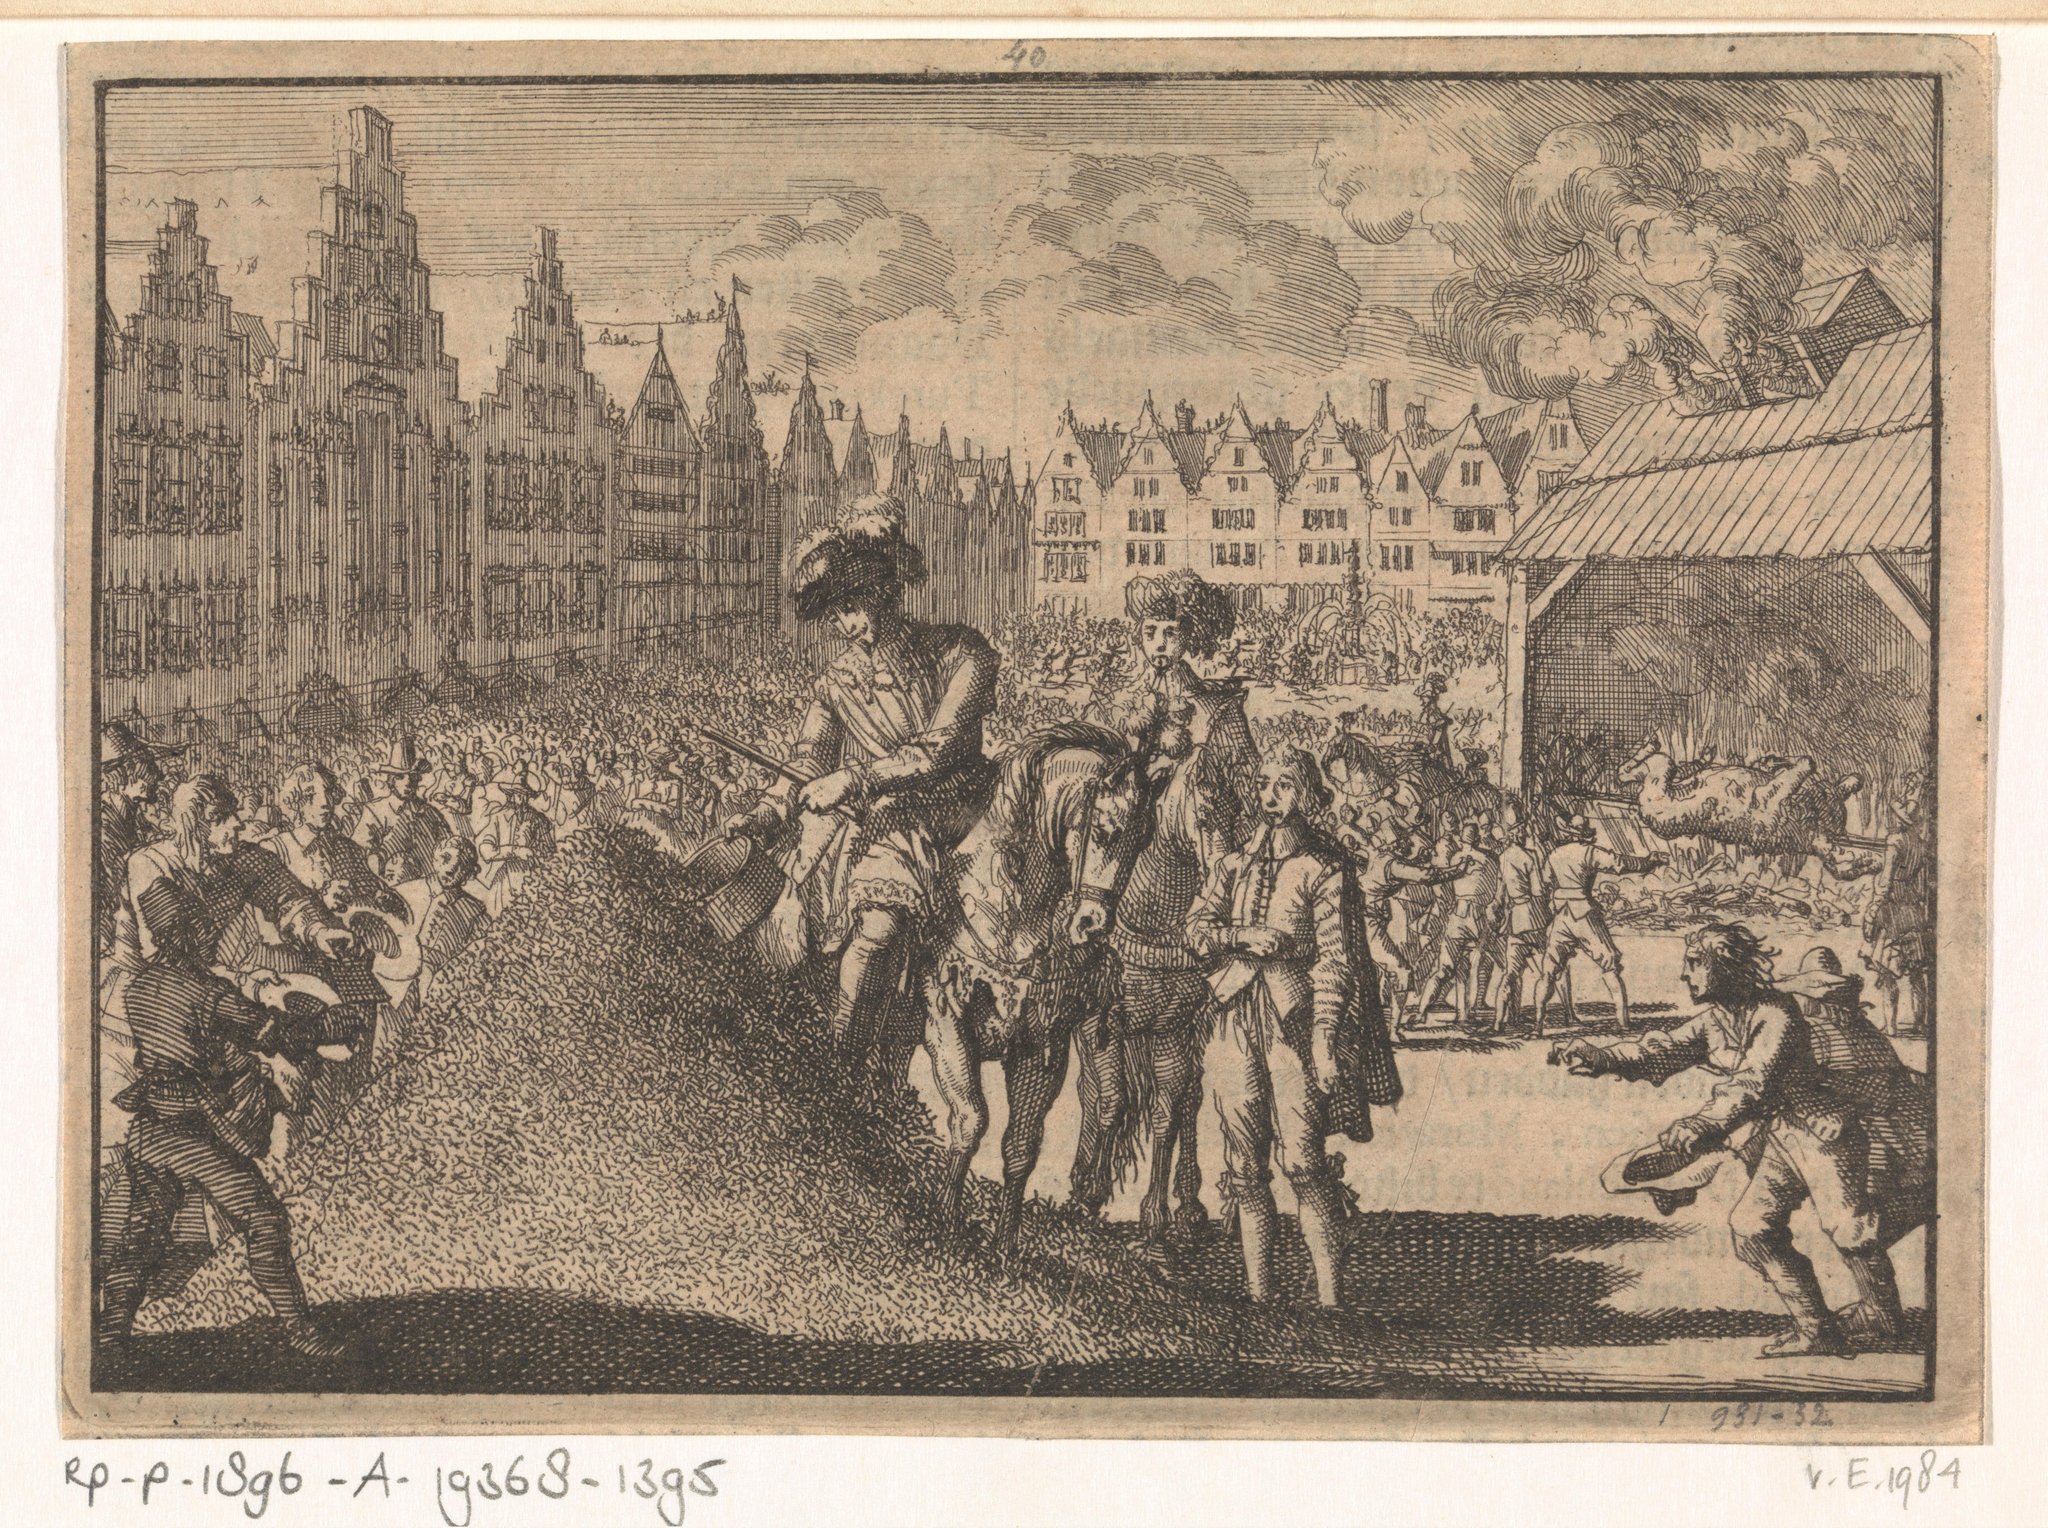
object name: book illustration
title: Grote Markt te Frankfurt am Main tijdens de kroning van keizer Ferdinand II, 1619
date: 1698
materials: paper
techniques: etching, letterpress printing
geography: amsterdam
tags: vienna, ferdinand ii (duits keizer), coronation of a ruler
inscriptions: collector's mark: Lugt 2228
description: Illustratie uit: Gottfried, Johann Ludwig. Historische kronyck; vervattende een (...) beschrijvingh der aldergedenckwaerdigste geschiedenissen des weerelds, van den aenvangh der scheppingh tot (...) 1576 (2 delen). Leiden: Pieter van der Aa, 1698, dl. I, p. 931.